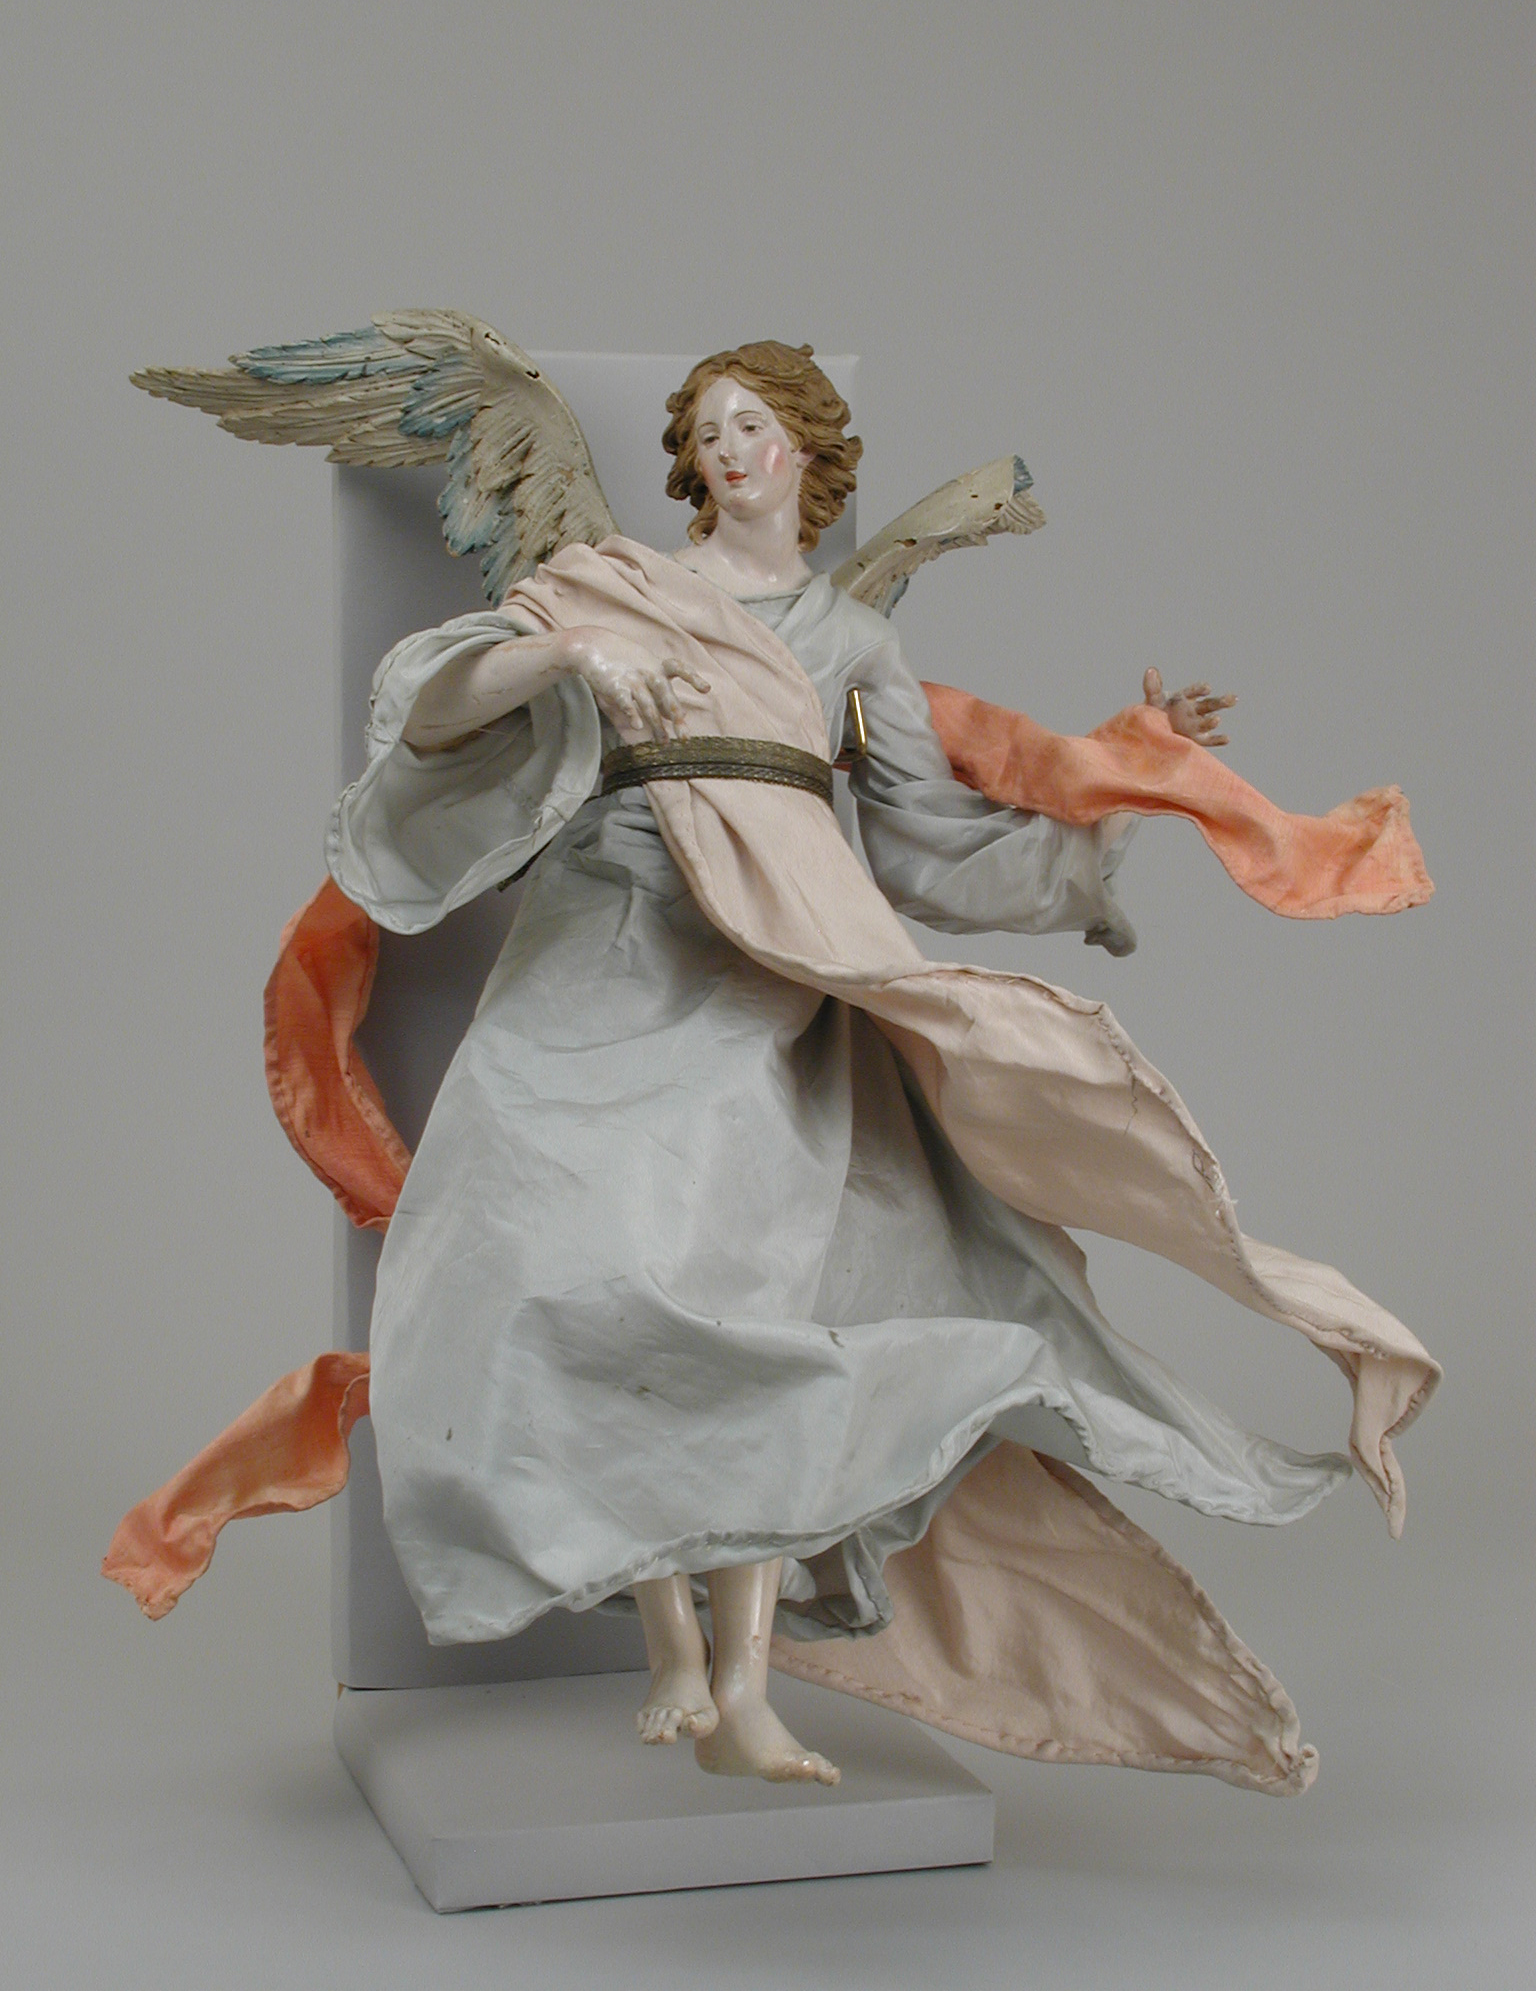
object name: crèche figure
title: Angel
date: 1701-1900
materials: terracotta, fiber, metal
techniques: polychrome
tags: angels